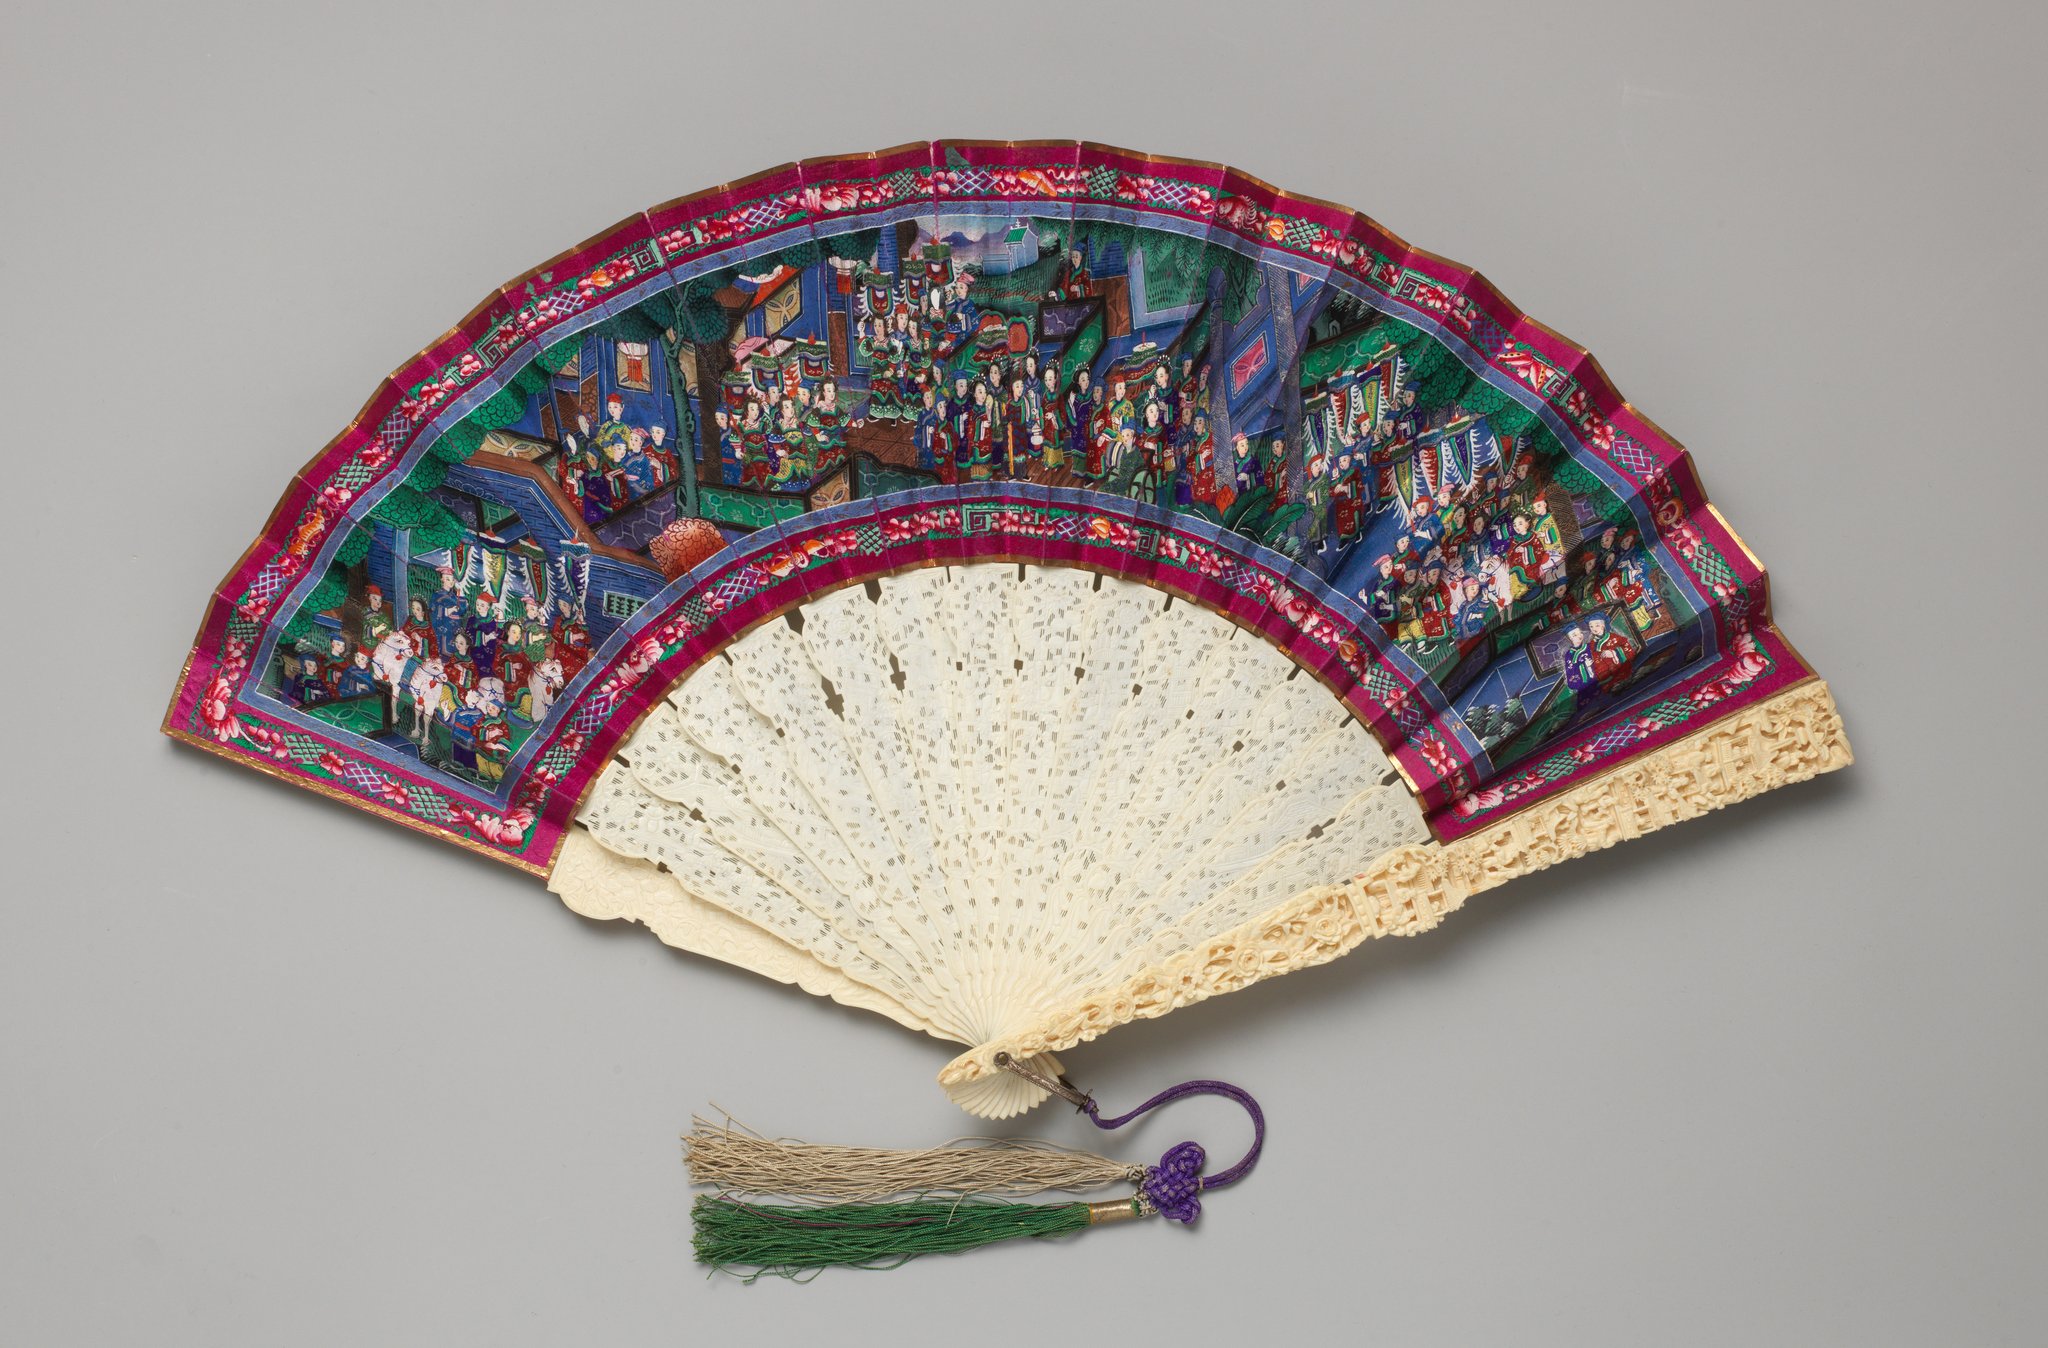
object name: fan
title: Folding Fan with Scene of Figures in a Courtyard Garden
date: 1801-1900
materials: ivory, paper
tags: men,women